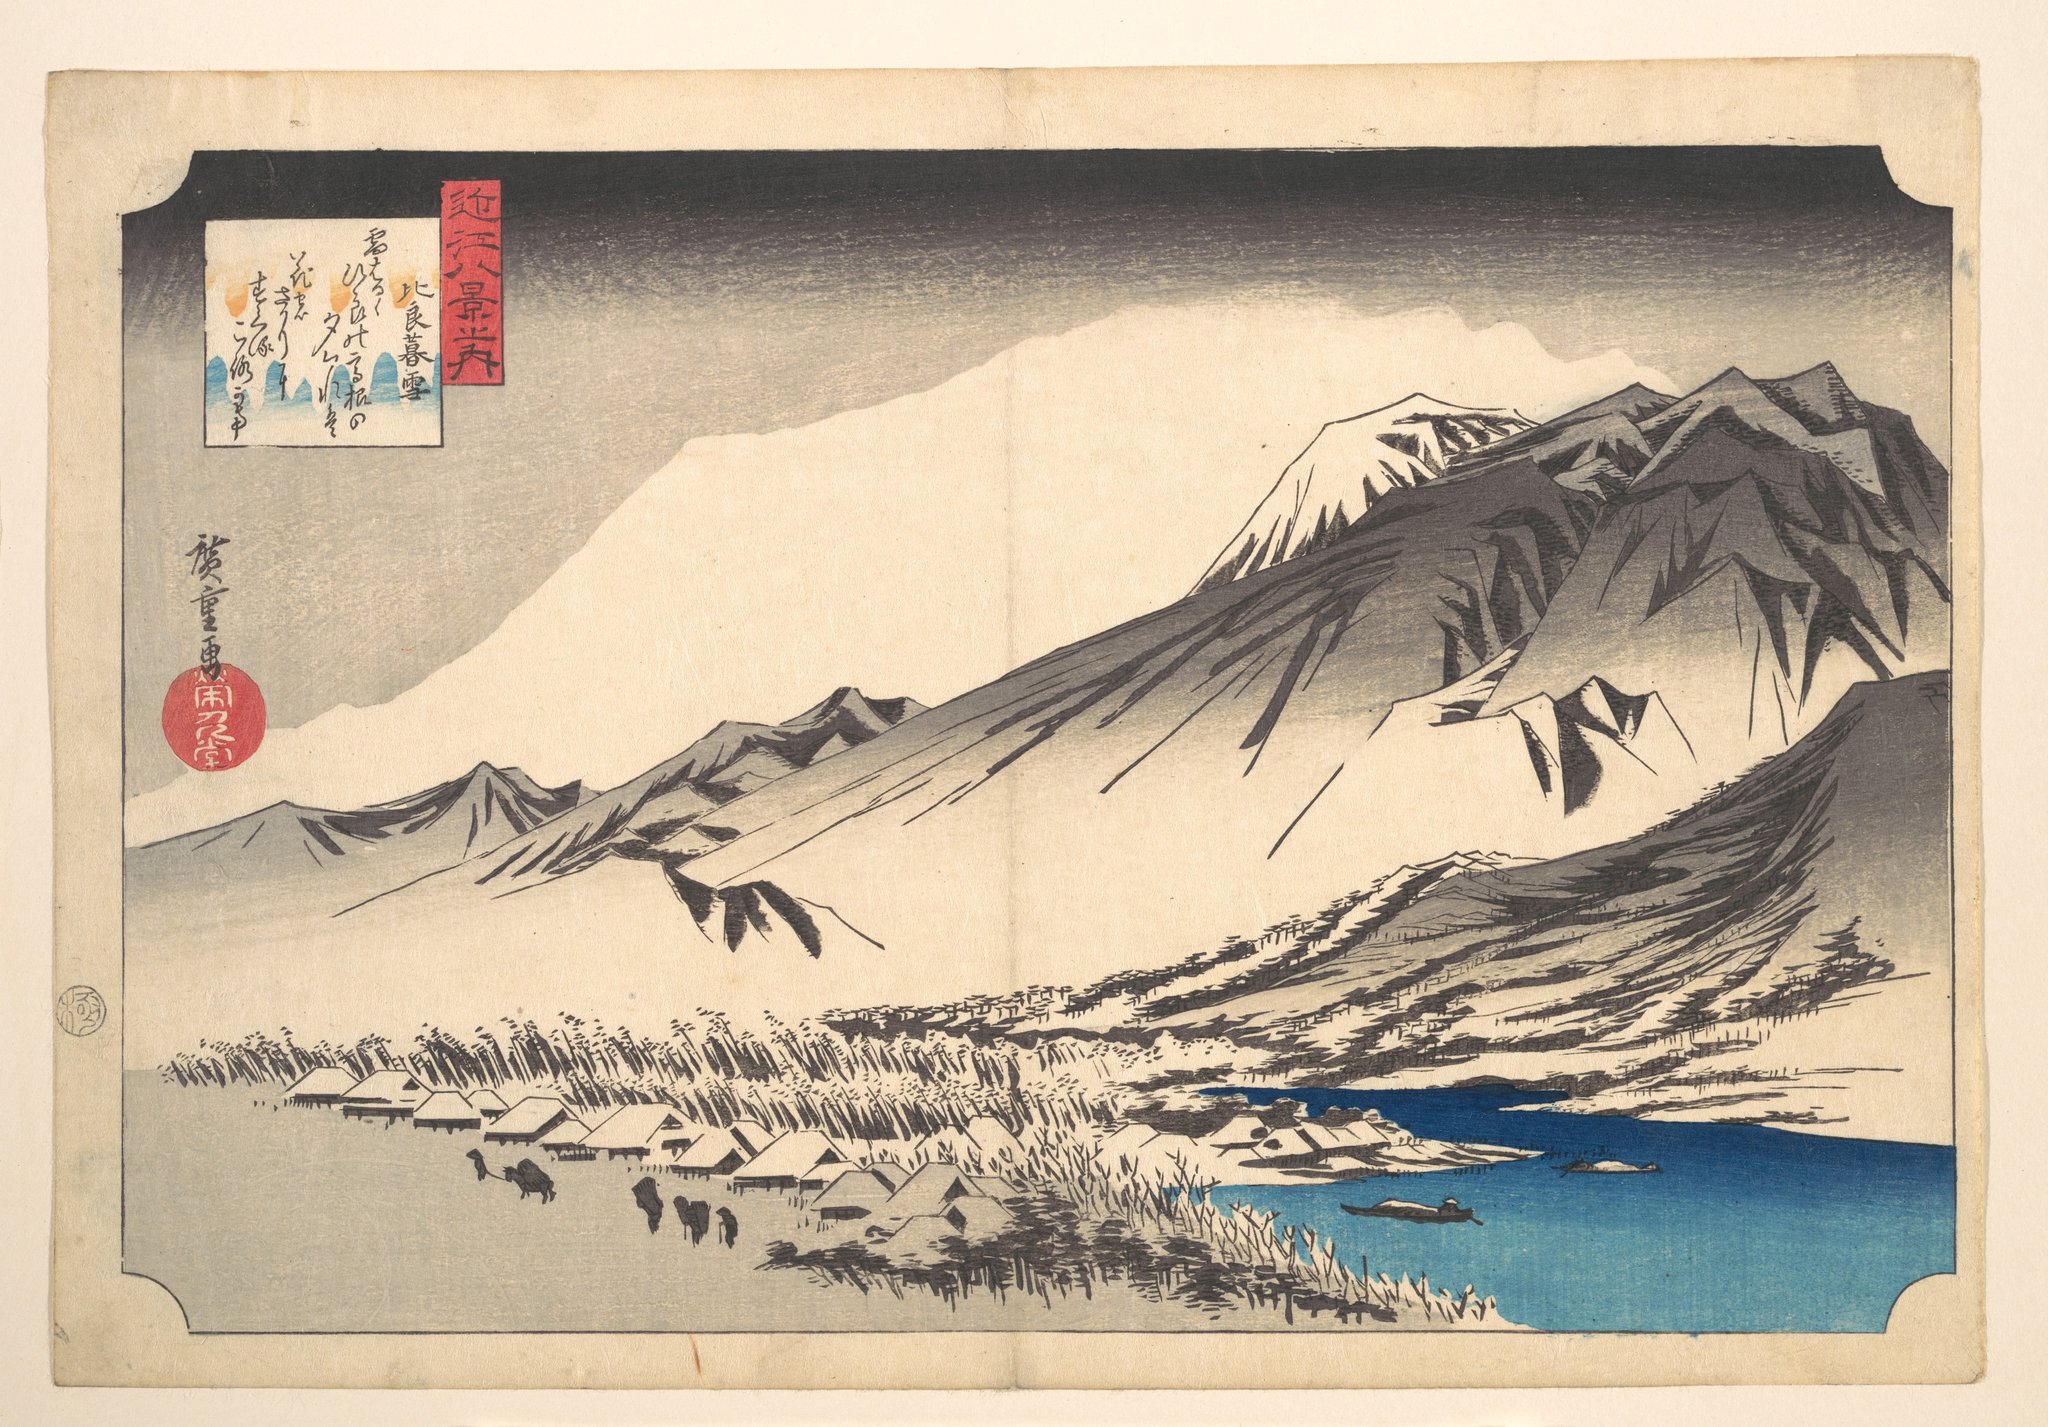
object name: print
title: Evening Snow on Mount Hira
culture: japanese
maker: utagawa hiroshige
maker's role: artist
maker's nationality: japanese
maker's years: 1797-1858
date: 1832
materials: ink, paper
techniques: woodblock print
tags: houses,mountains,landscapes,boats